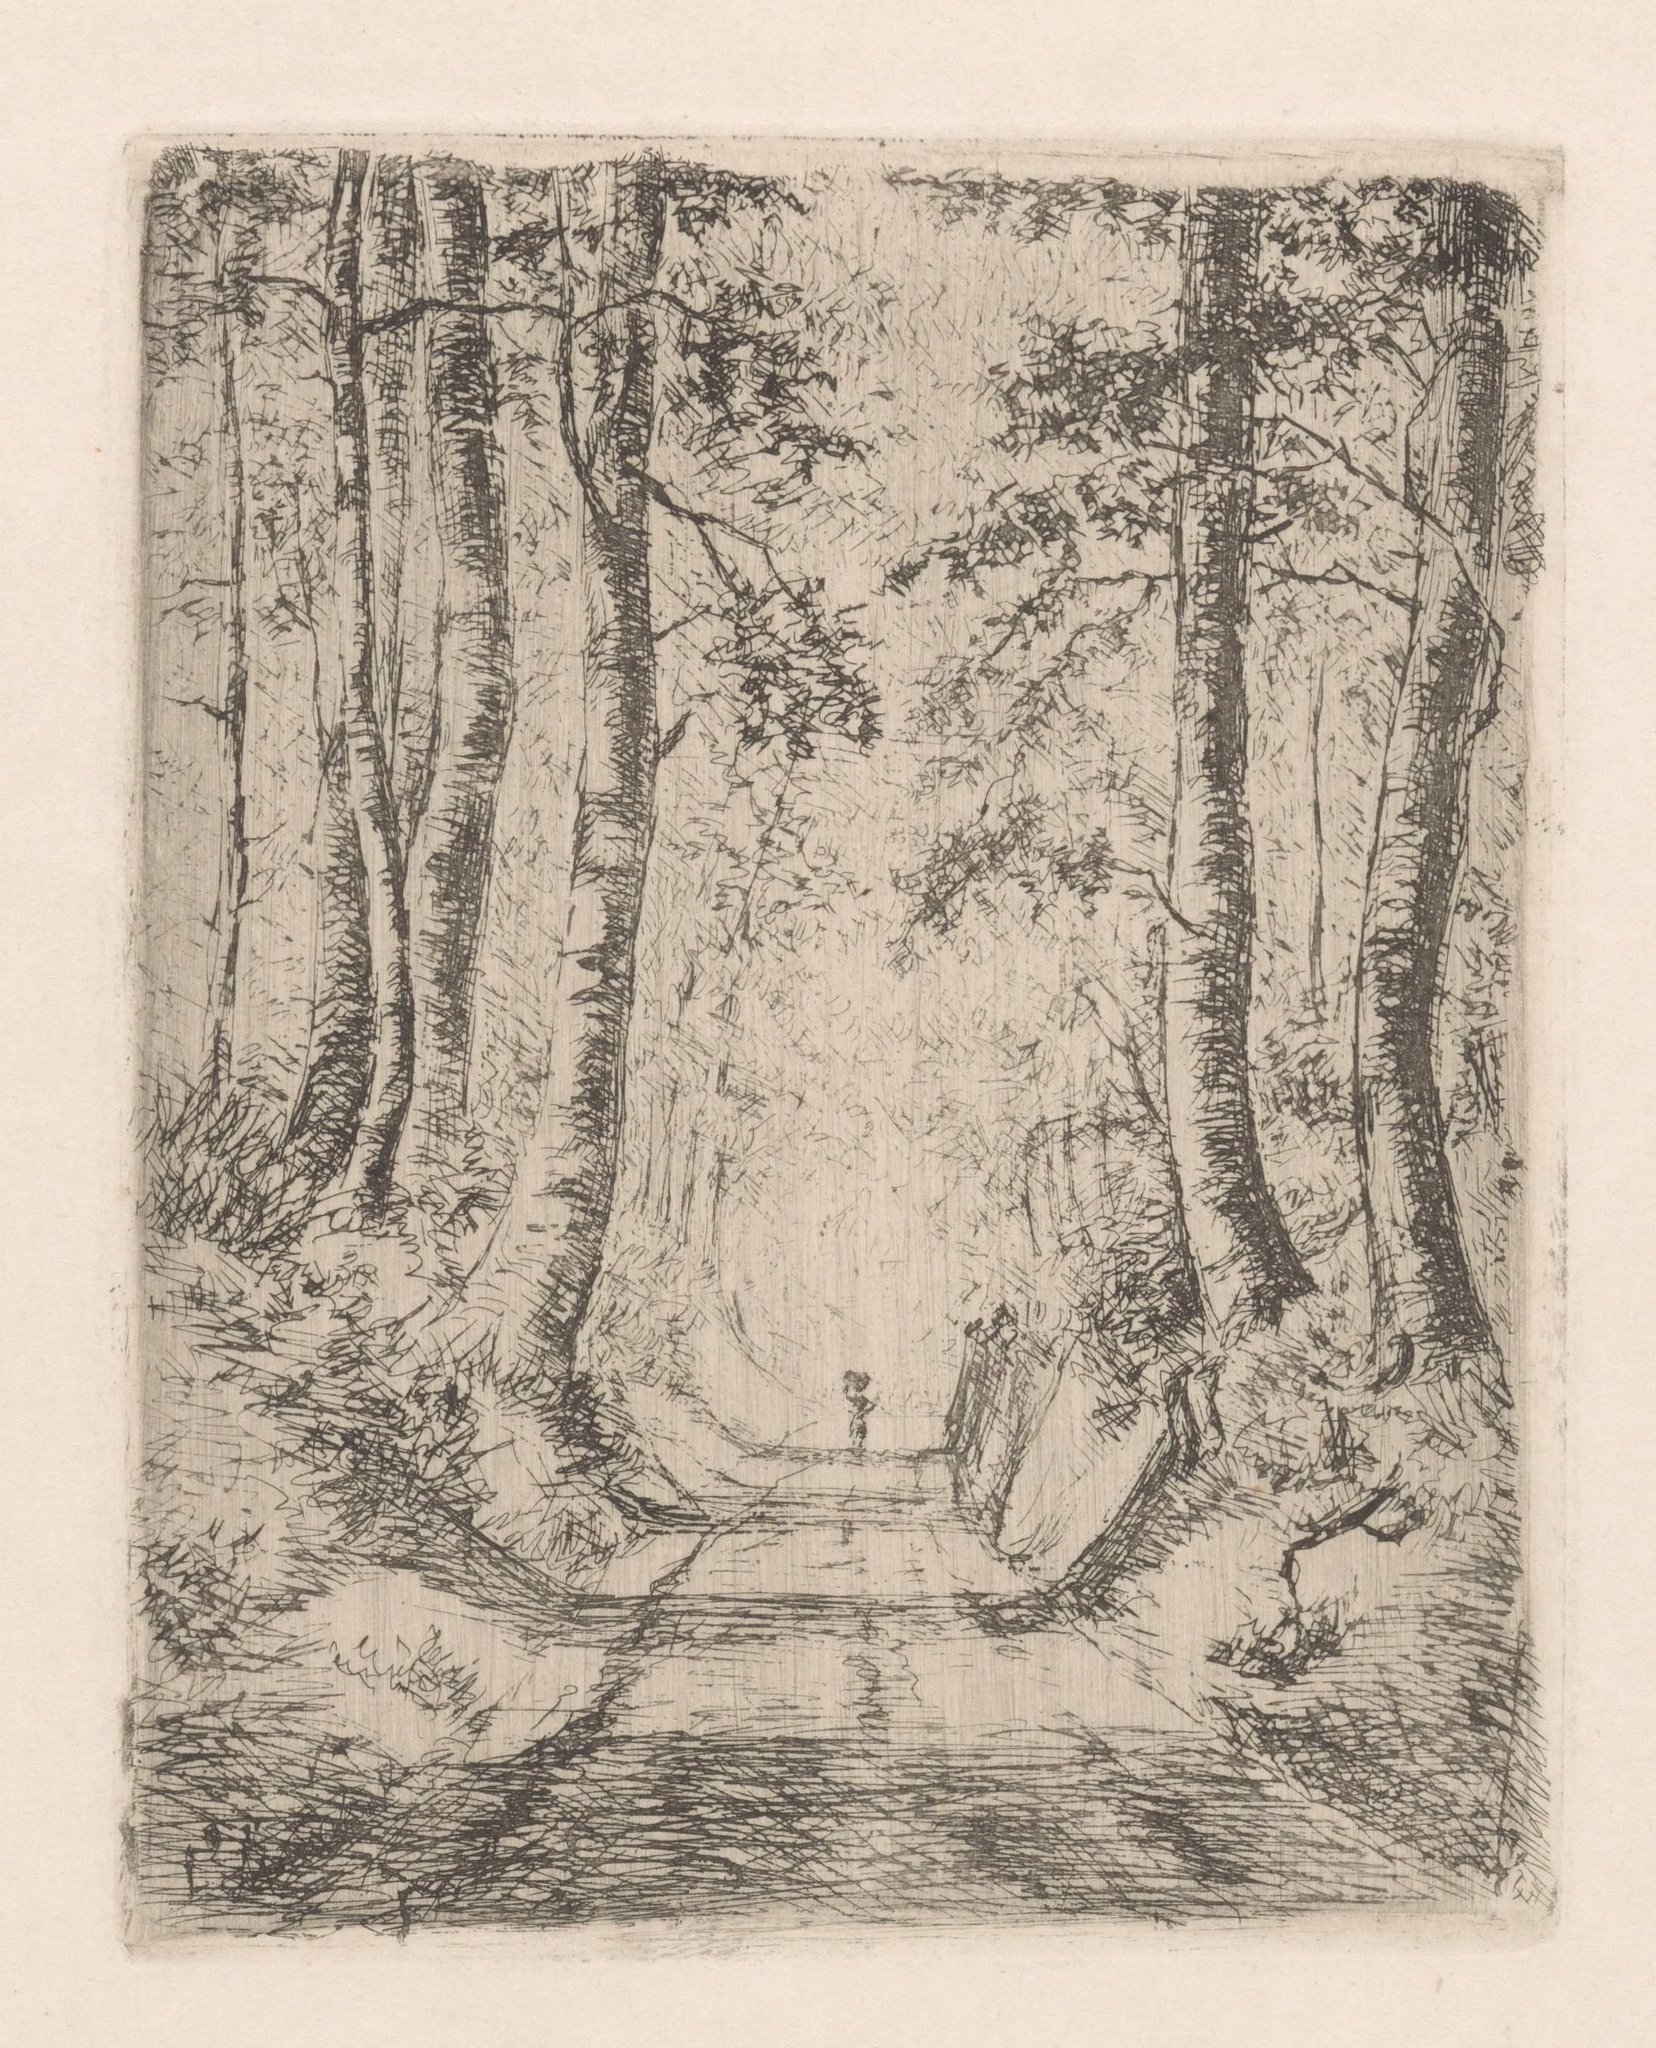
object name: print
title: Bos langs een holle weg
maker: marie adolphine van der goes van dirxland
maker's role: draughtsman, print maker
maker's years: 1844-1926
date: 1854-1878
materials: paper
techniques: etching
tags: forest path or lane, carrying something on the head or on the shoulders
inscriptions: collector's mark: Lugt 2228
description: Op de weg loopt een figuur die een mand op het hoofd draagt.